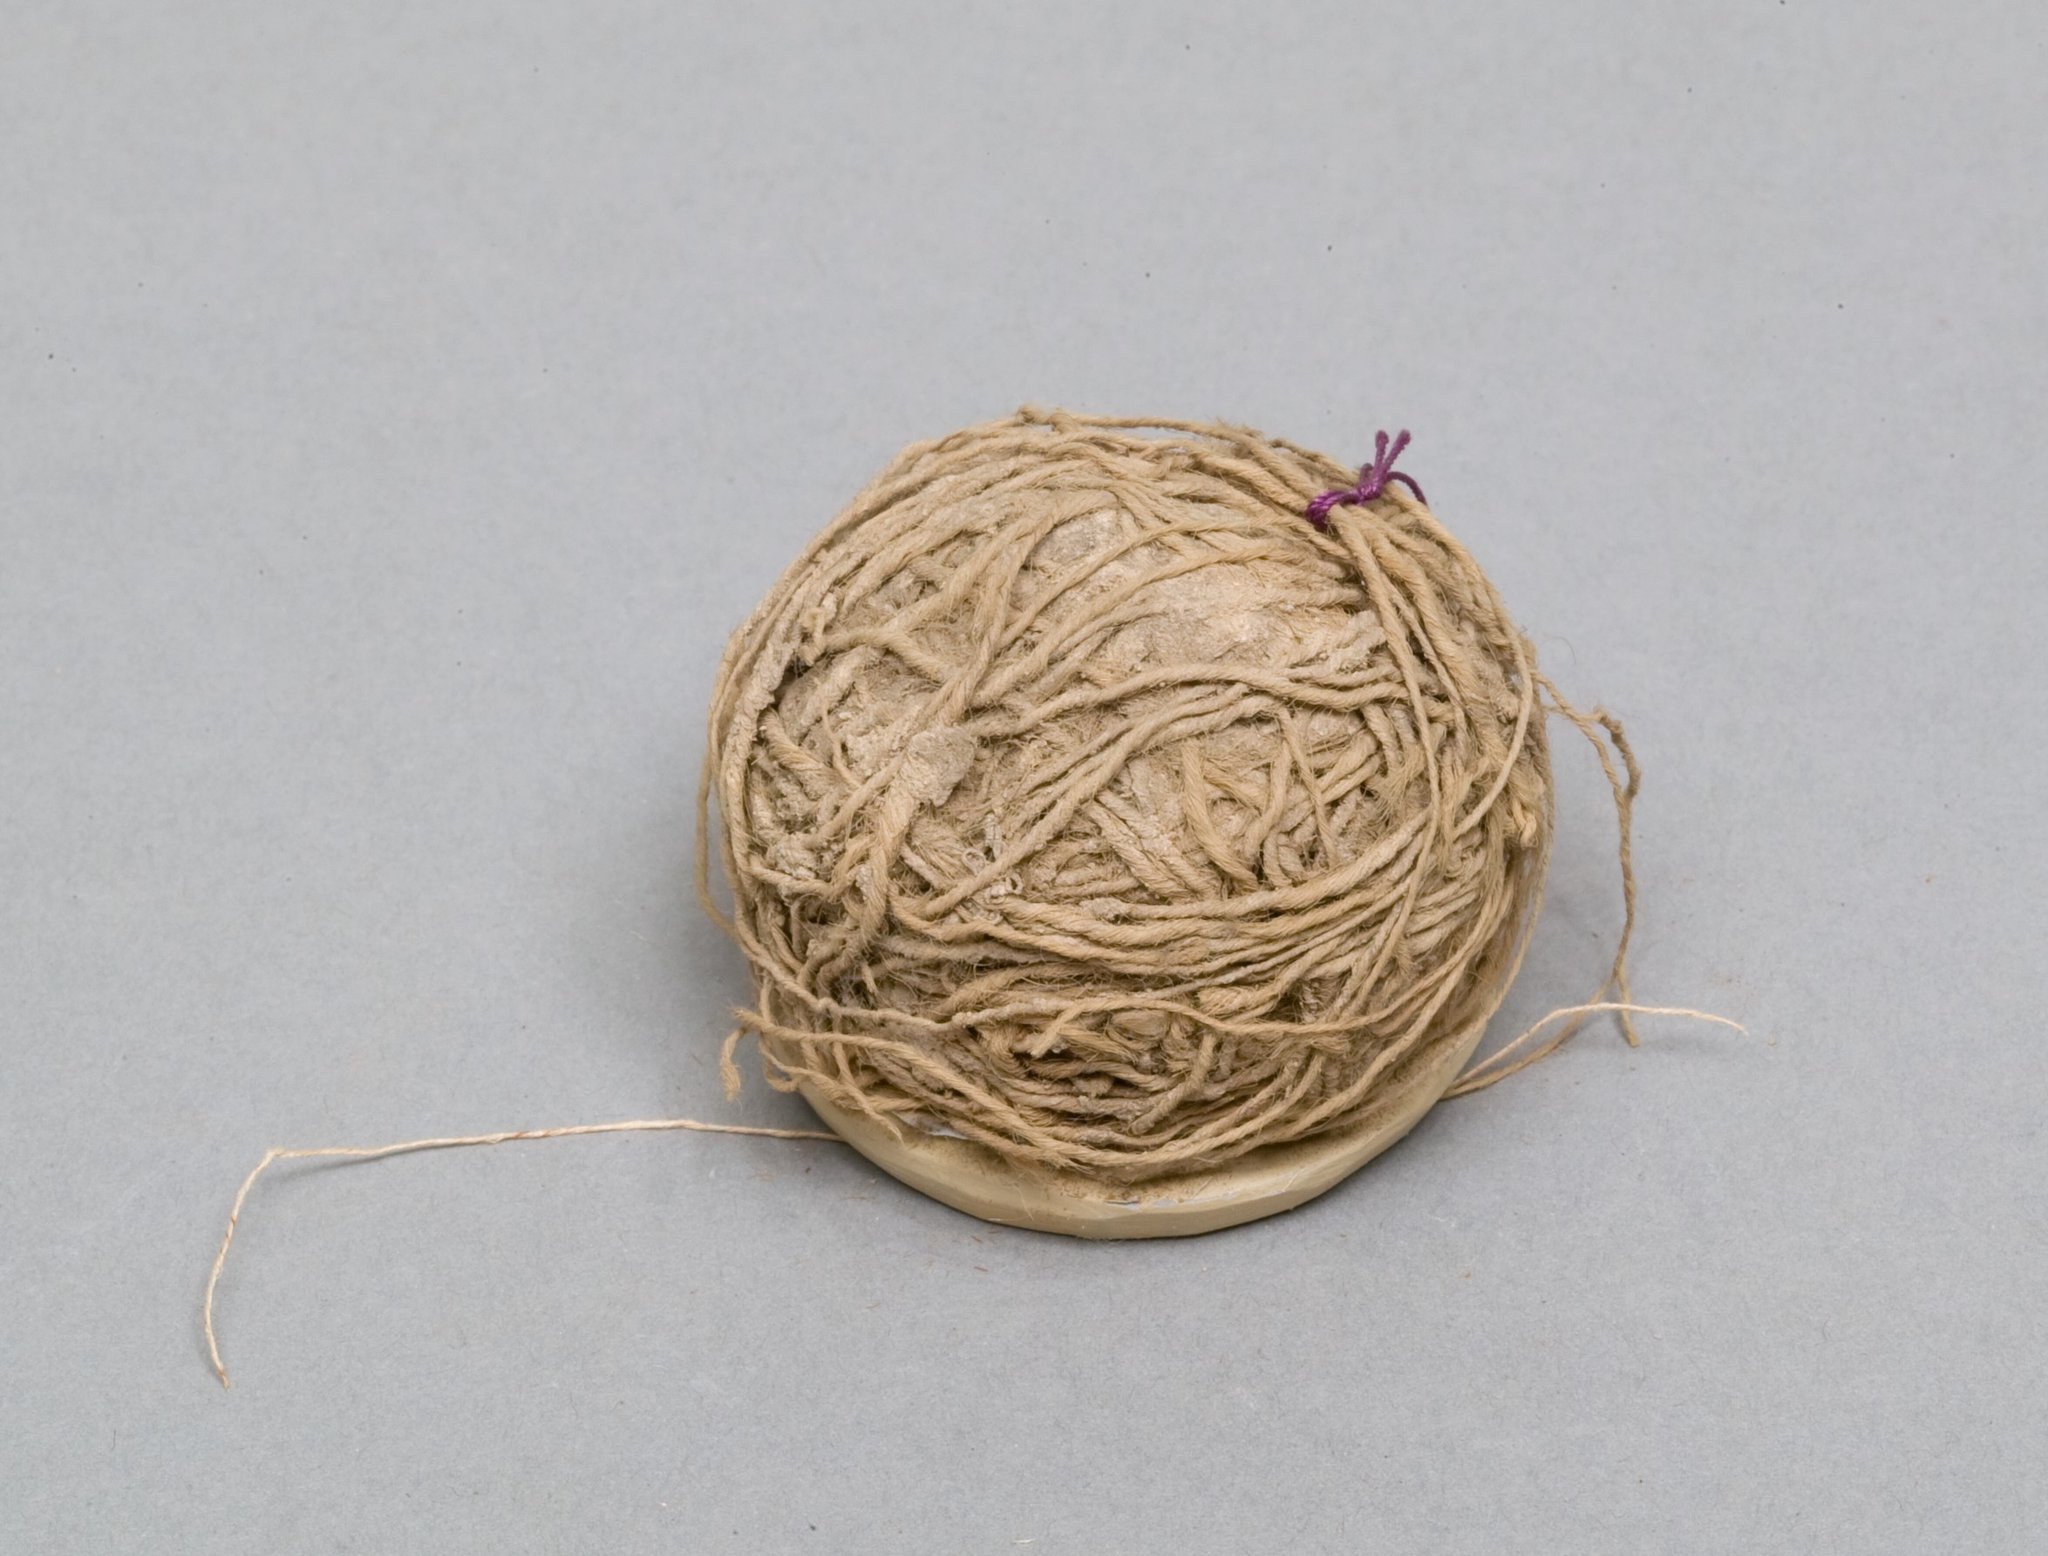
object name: linen, wool thread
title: Ball of thread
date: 1295-1070 BCE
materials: linen, wool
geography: egypt